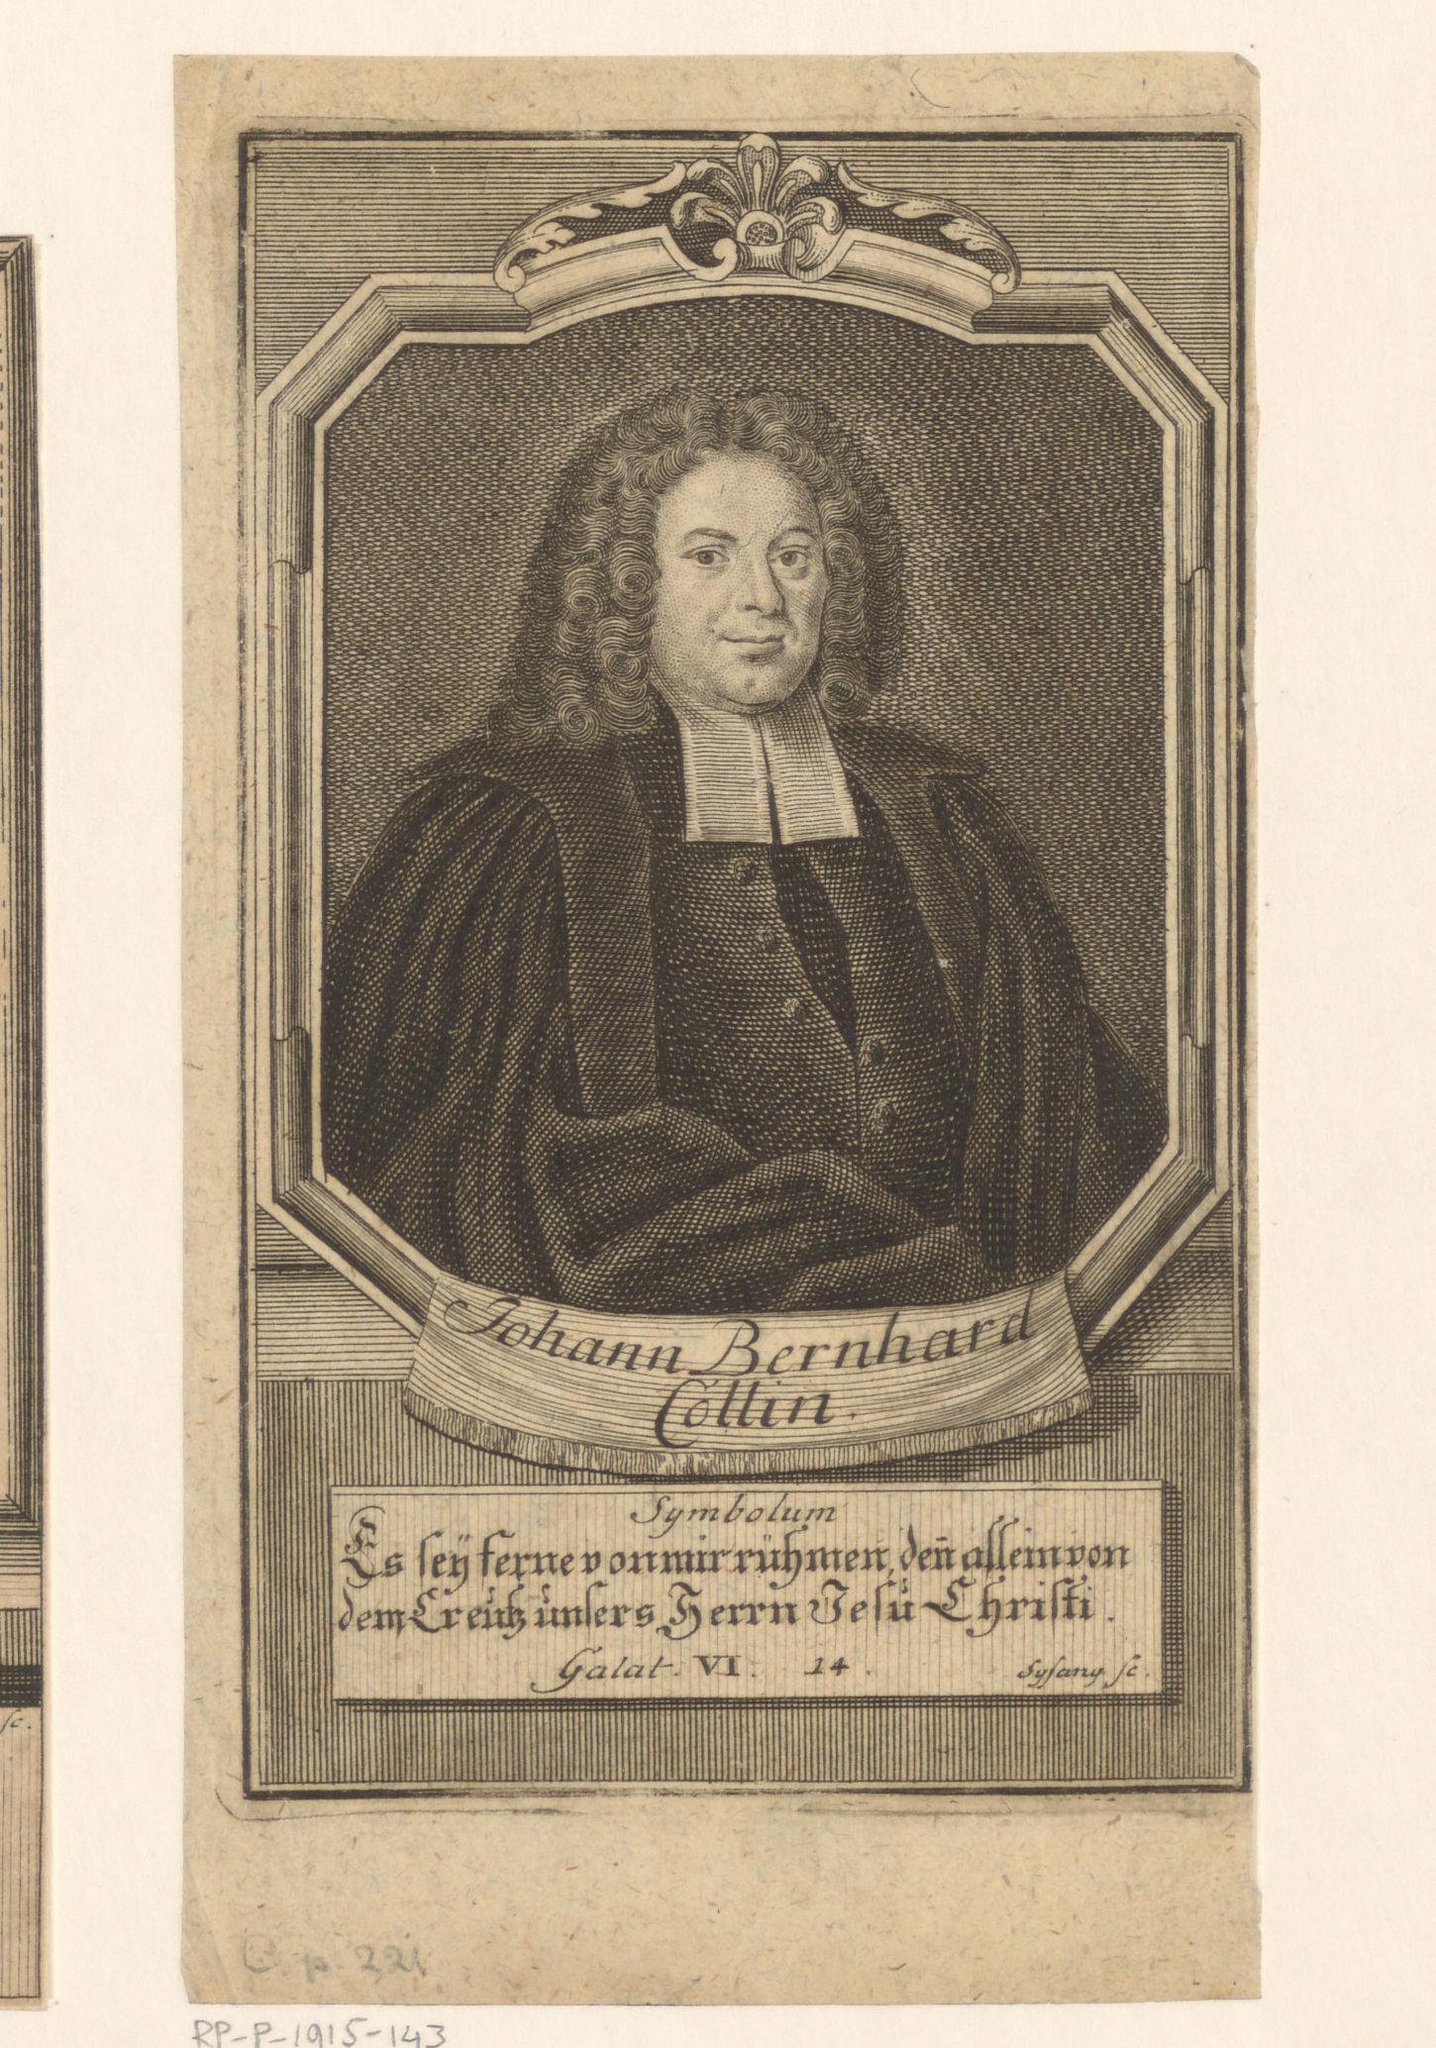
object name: print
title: Portret van Johann Bernhard Collin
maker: johann christoph sysang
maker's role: print maker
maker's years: 1703-1757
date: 1713-1757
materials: paper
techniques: engraving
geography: germany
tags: historical persons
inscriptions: collector's mark: Lugt 2228